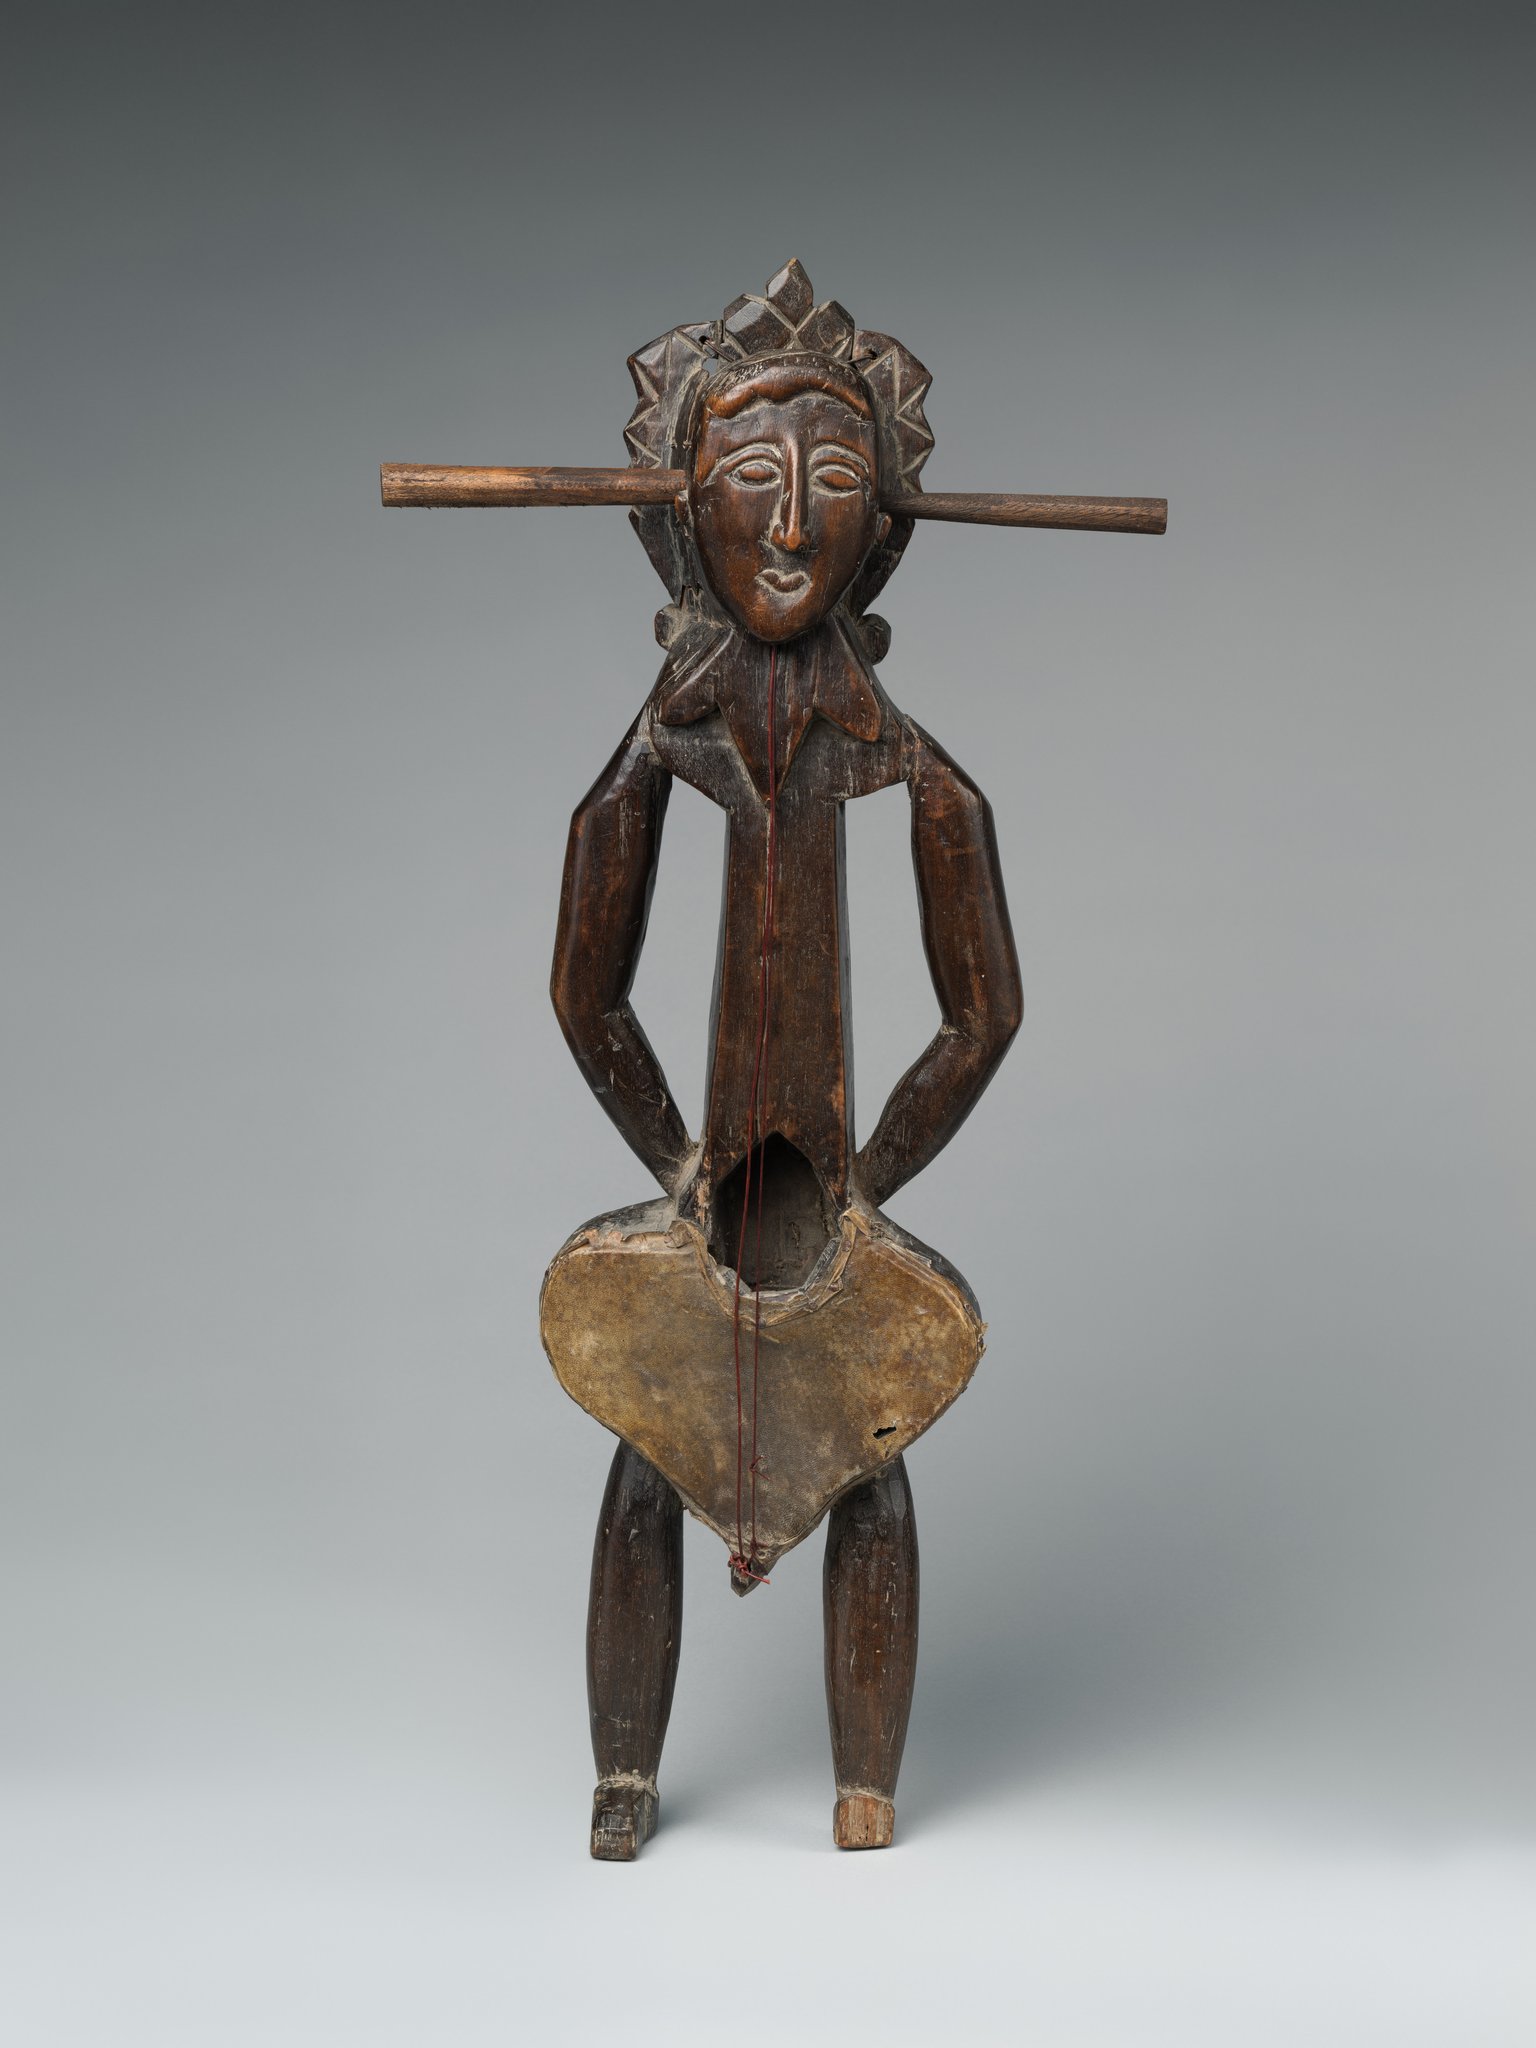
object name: a santal lute dhodro banam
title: A Santal Lute (Dhodro Banam)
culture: eastern indian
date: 1801-1900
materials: wood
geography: india